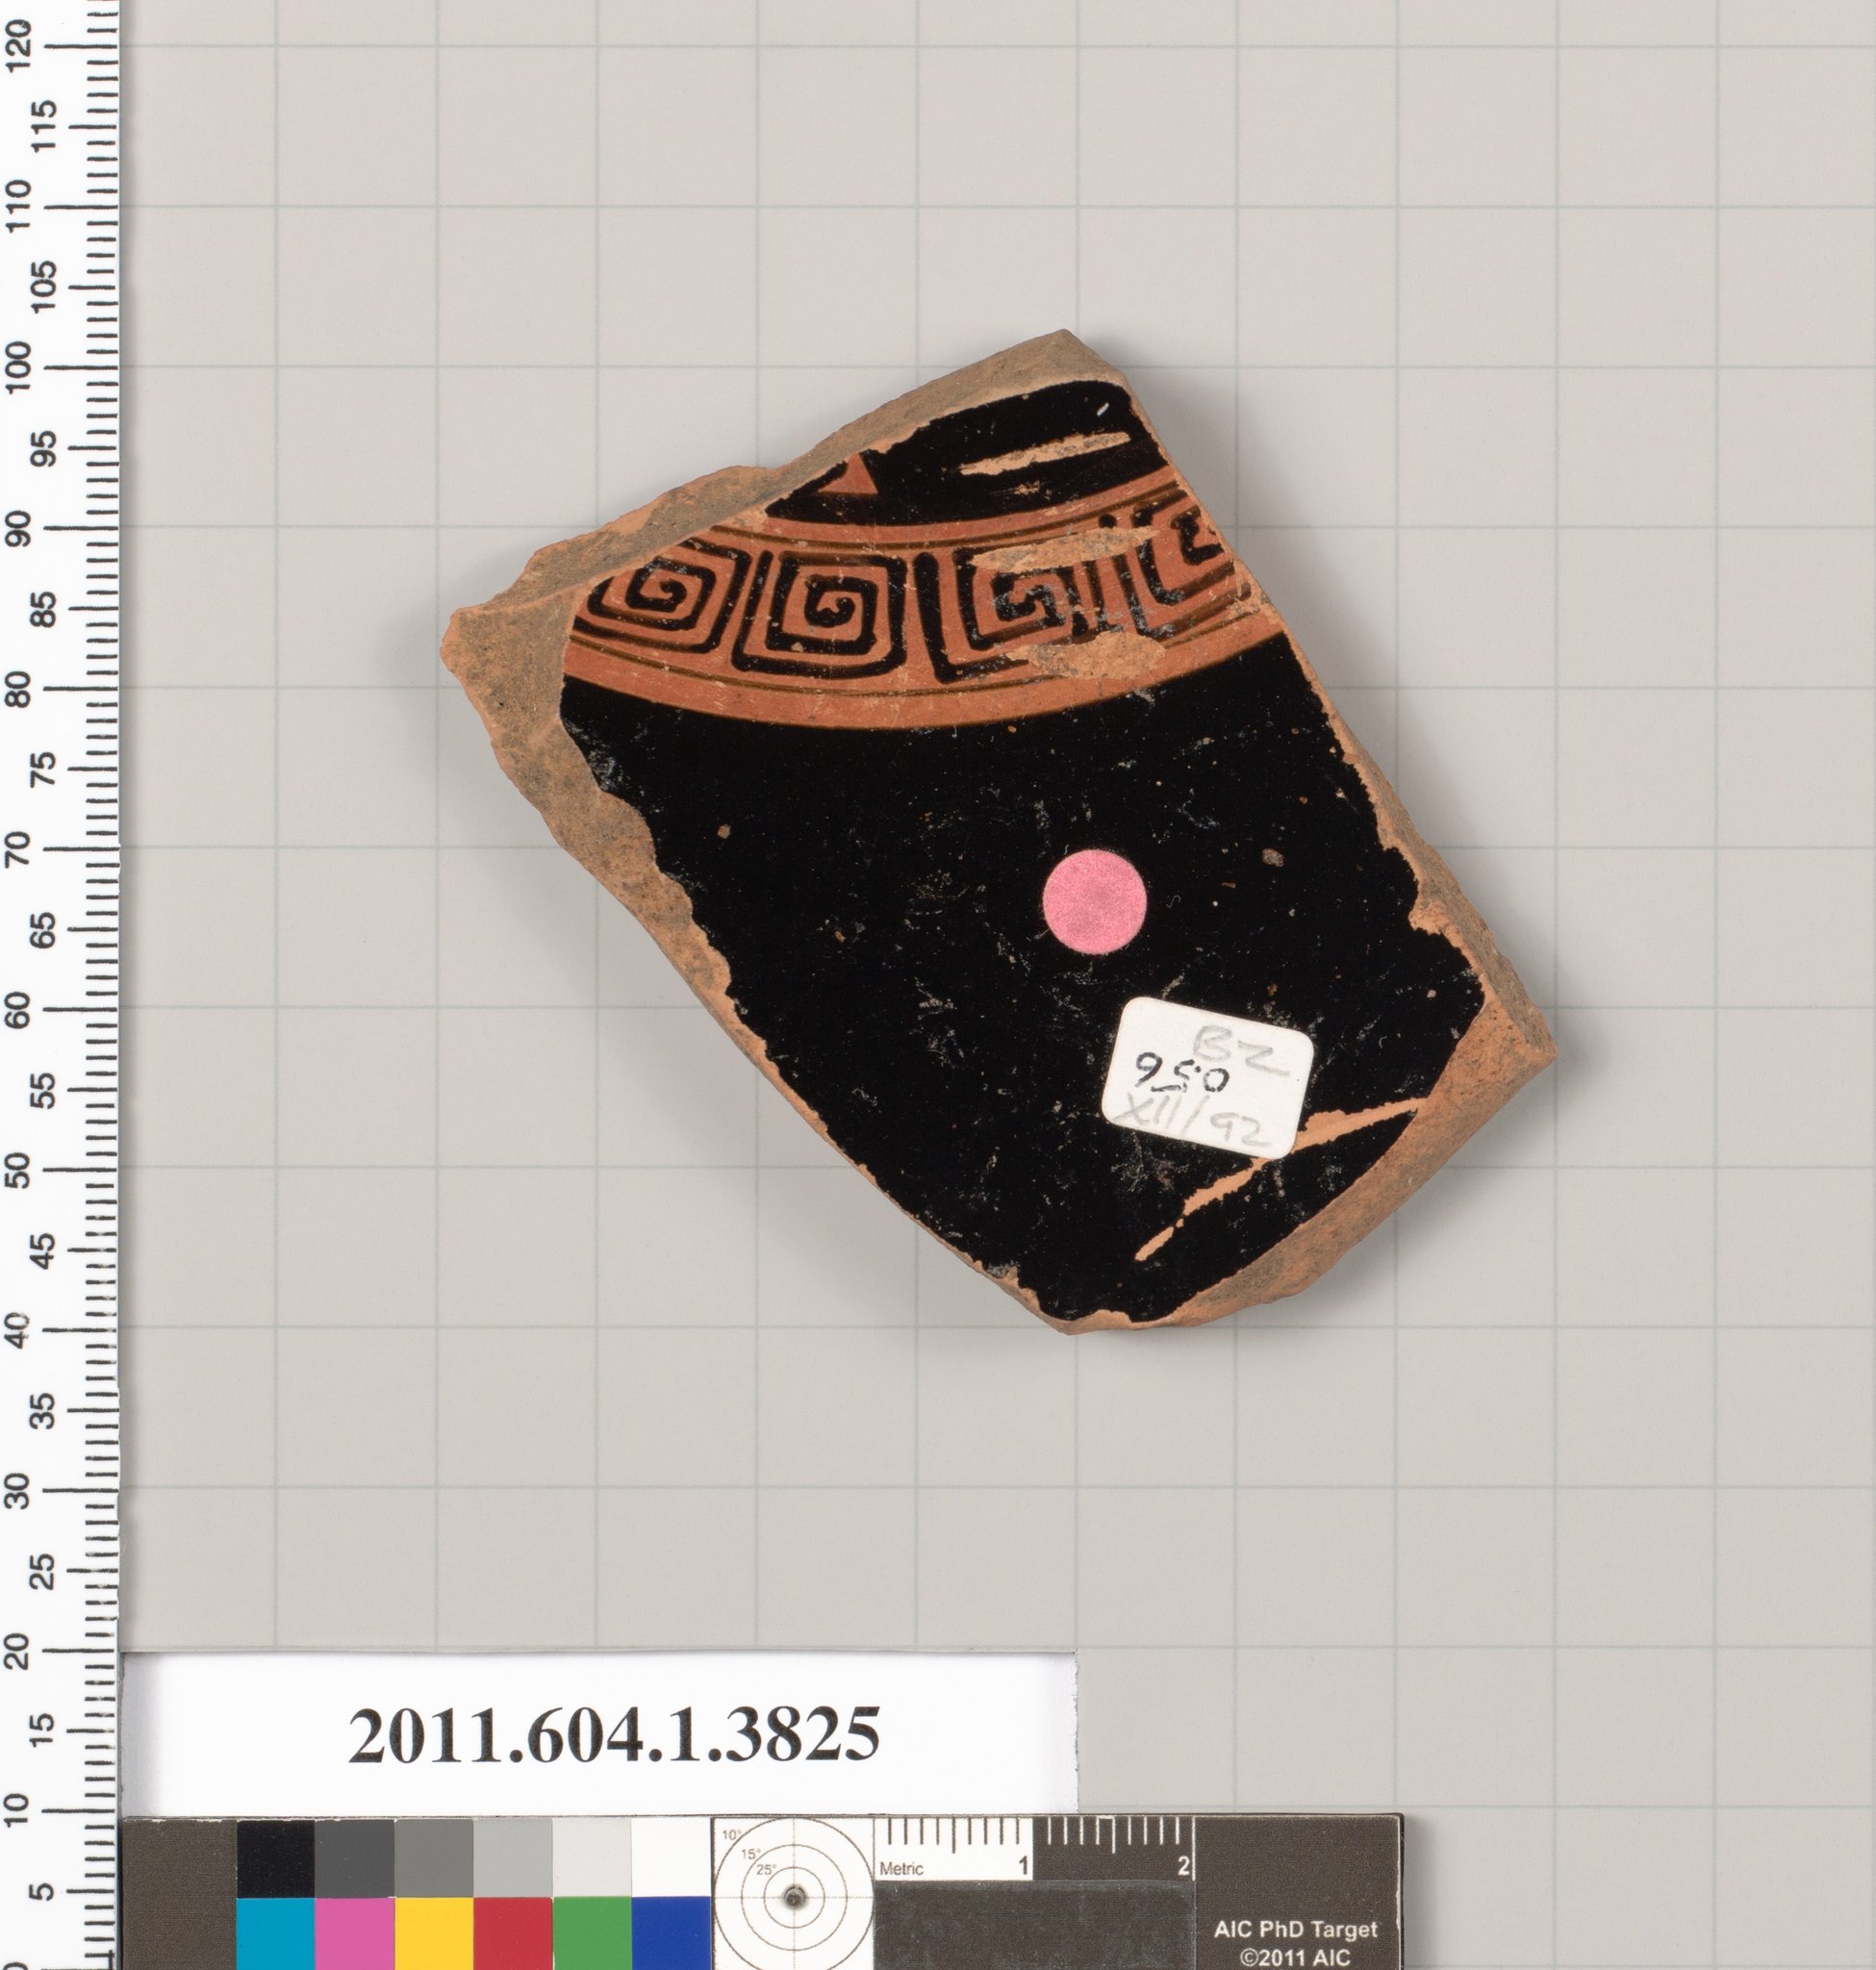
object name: kylix fragment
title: Terracotta fragment of a kylix (drinking cup)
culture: greek, attic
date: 460-450 BCE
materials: terracotta